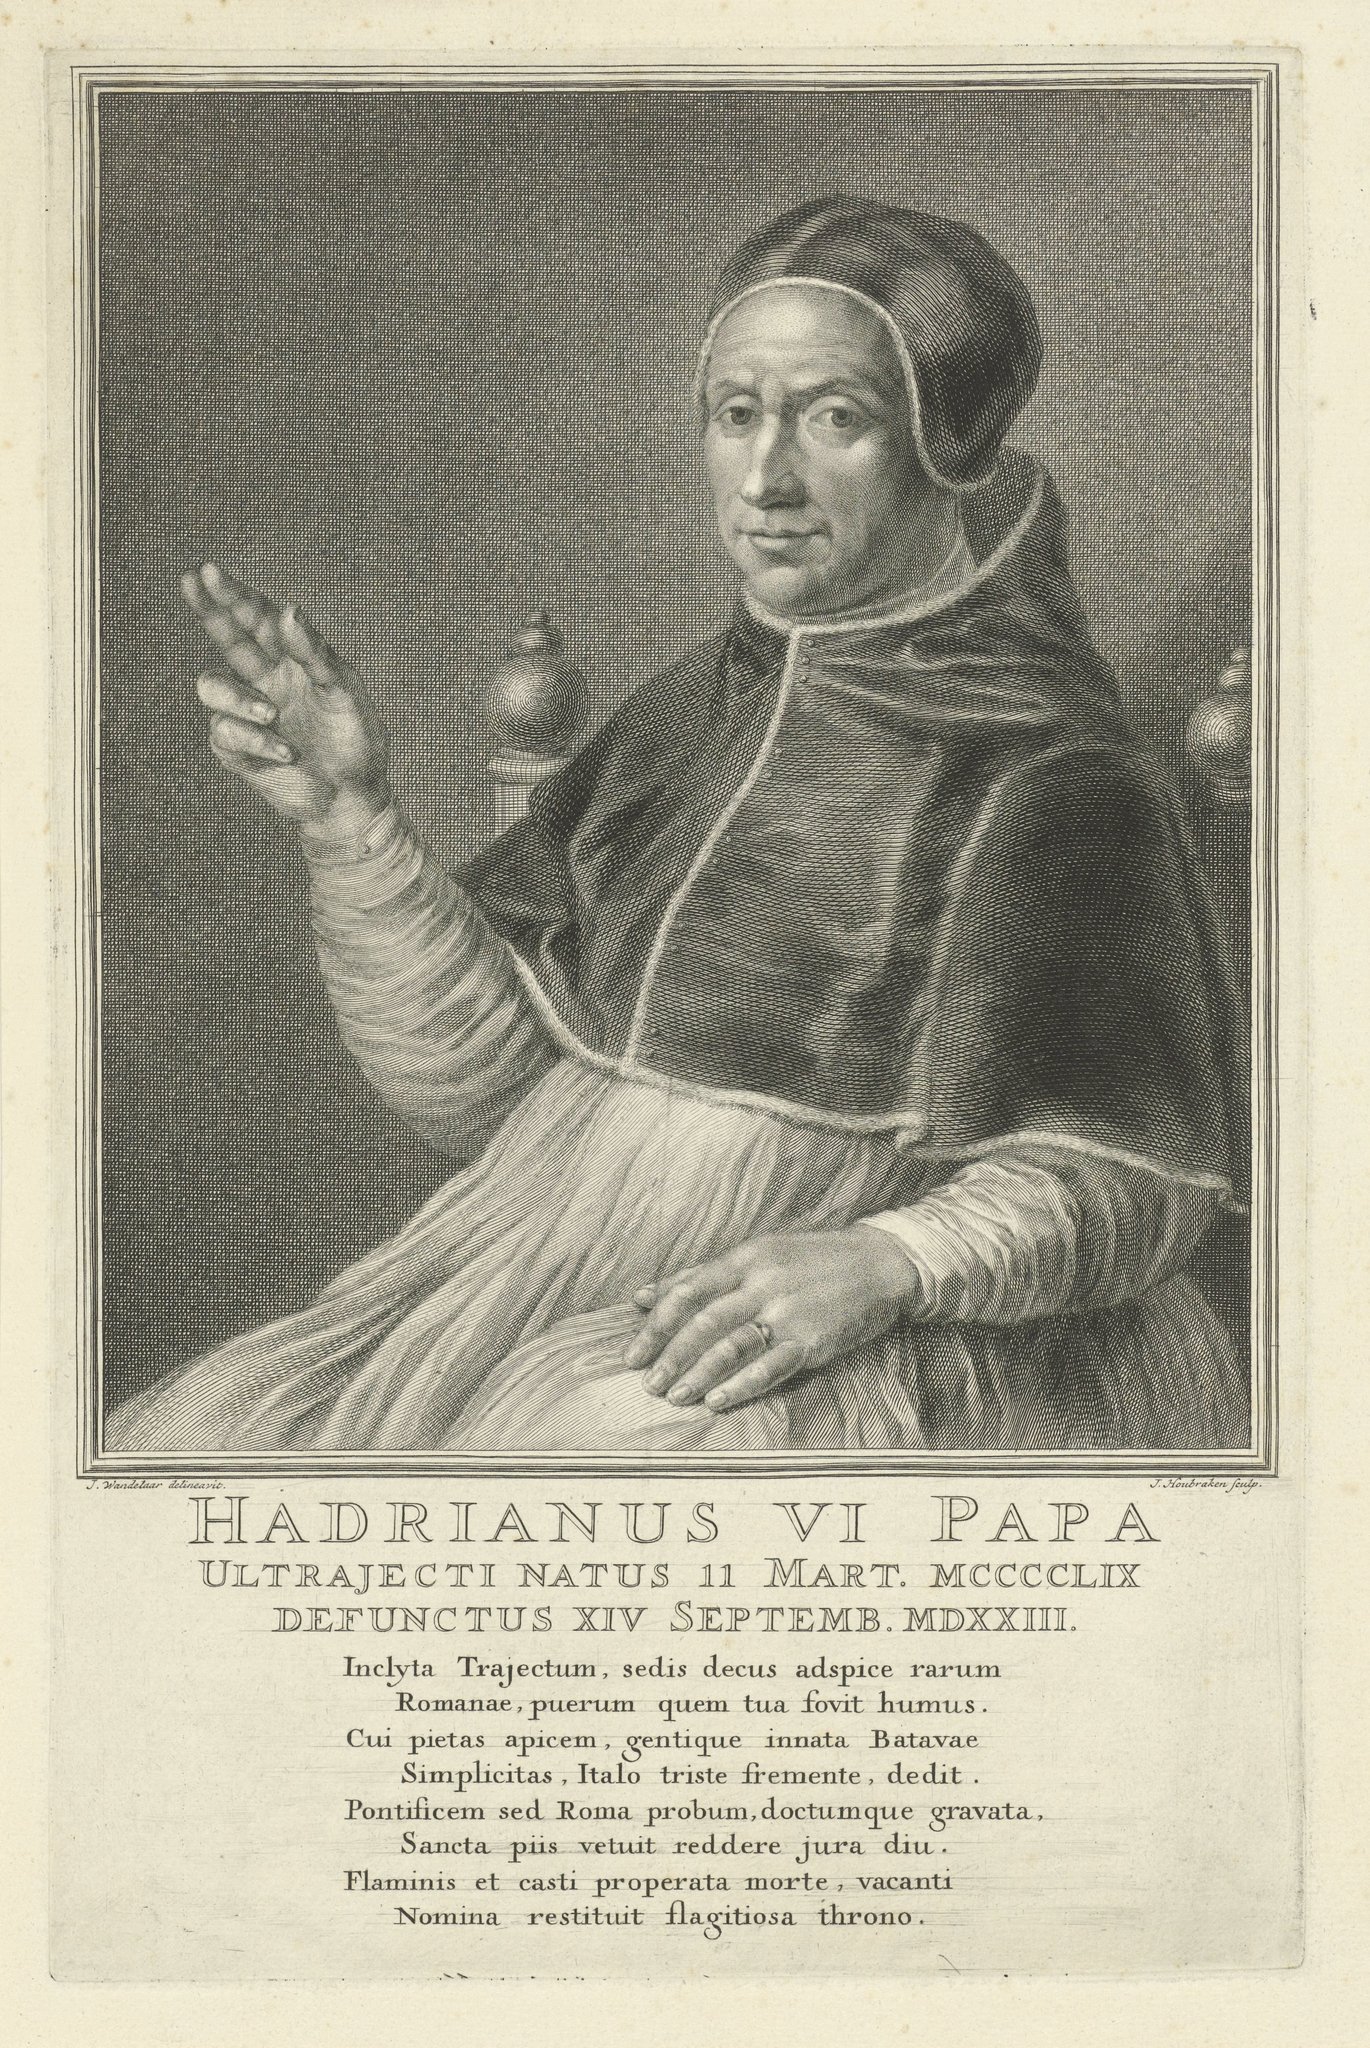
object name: print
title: Hadrianus VI Papa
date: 1708-1780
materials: paper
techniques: engraving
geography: amsterdam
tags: utrecht, rome, clergyman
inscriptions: collector's mark: Lugt 240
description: Kniestuk van paus Adrianus VI naar links, zittend in een stoel. Met zijn rechterhand maakt hij een zegenend gebaar. Onder het portret zijn naam en gegevens in drie regels in het Latijn en daaronder een achtregelige tekst in het Latijn.